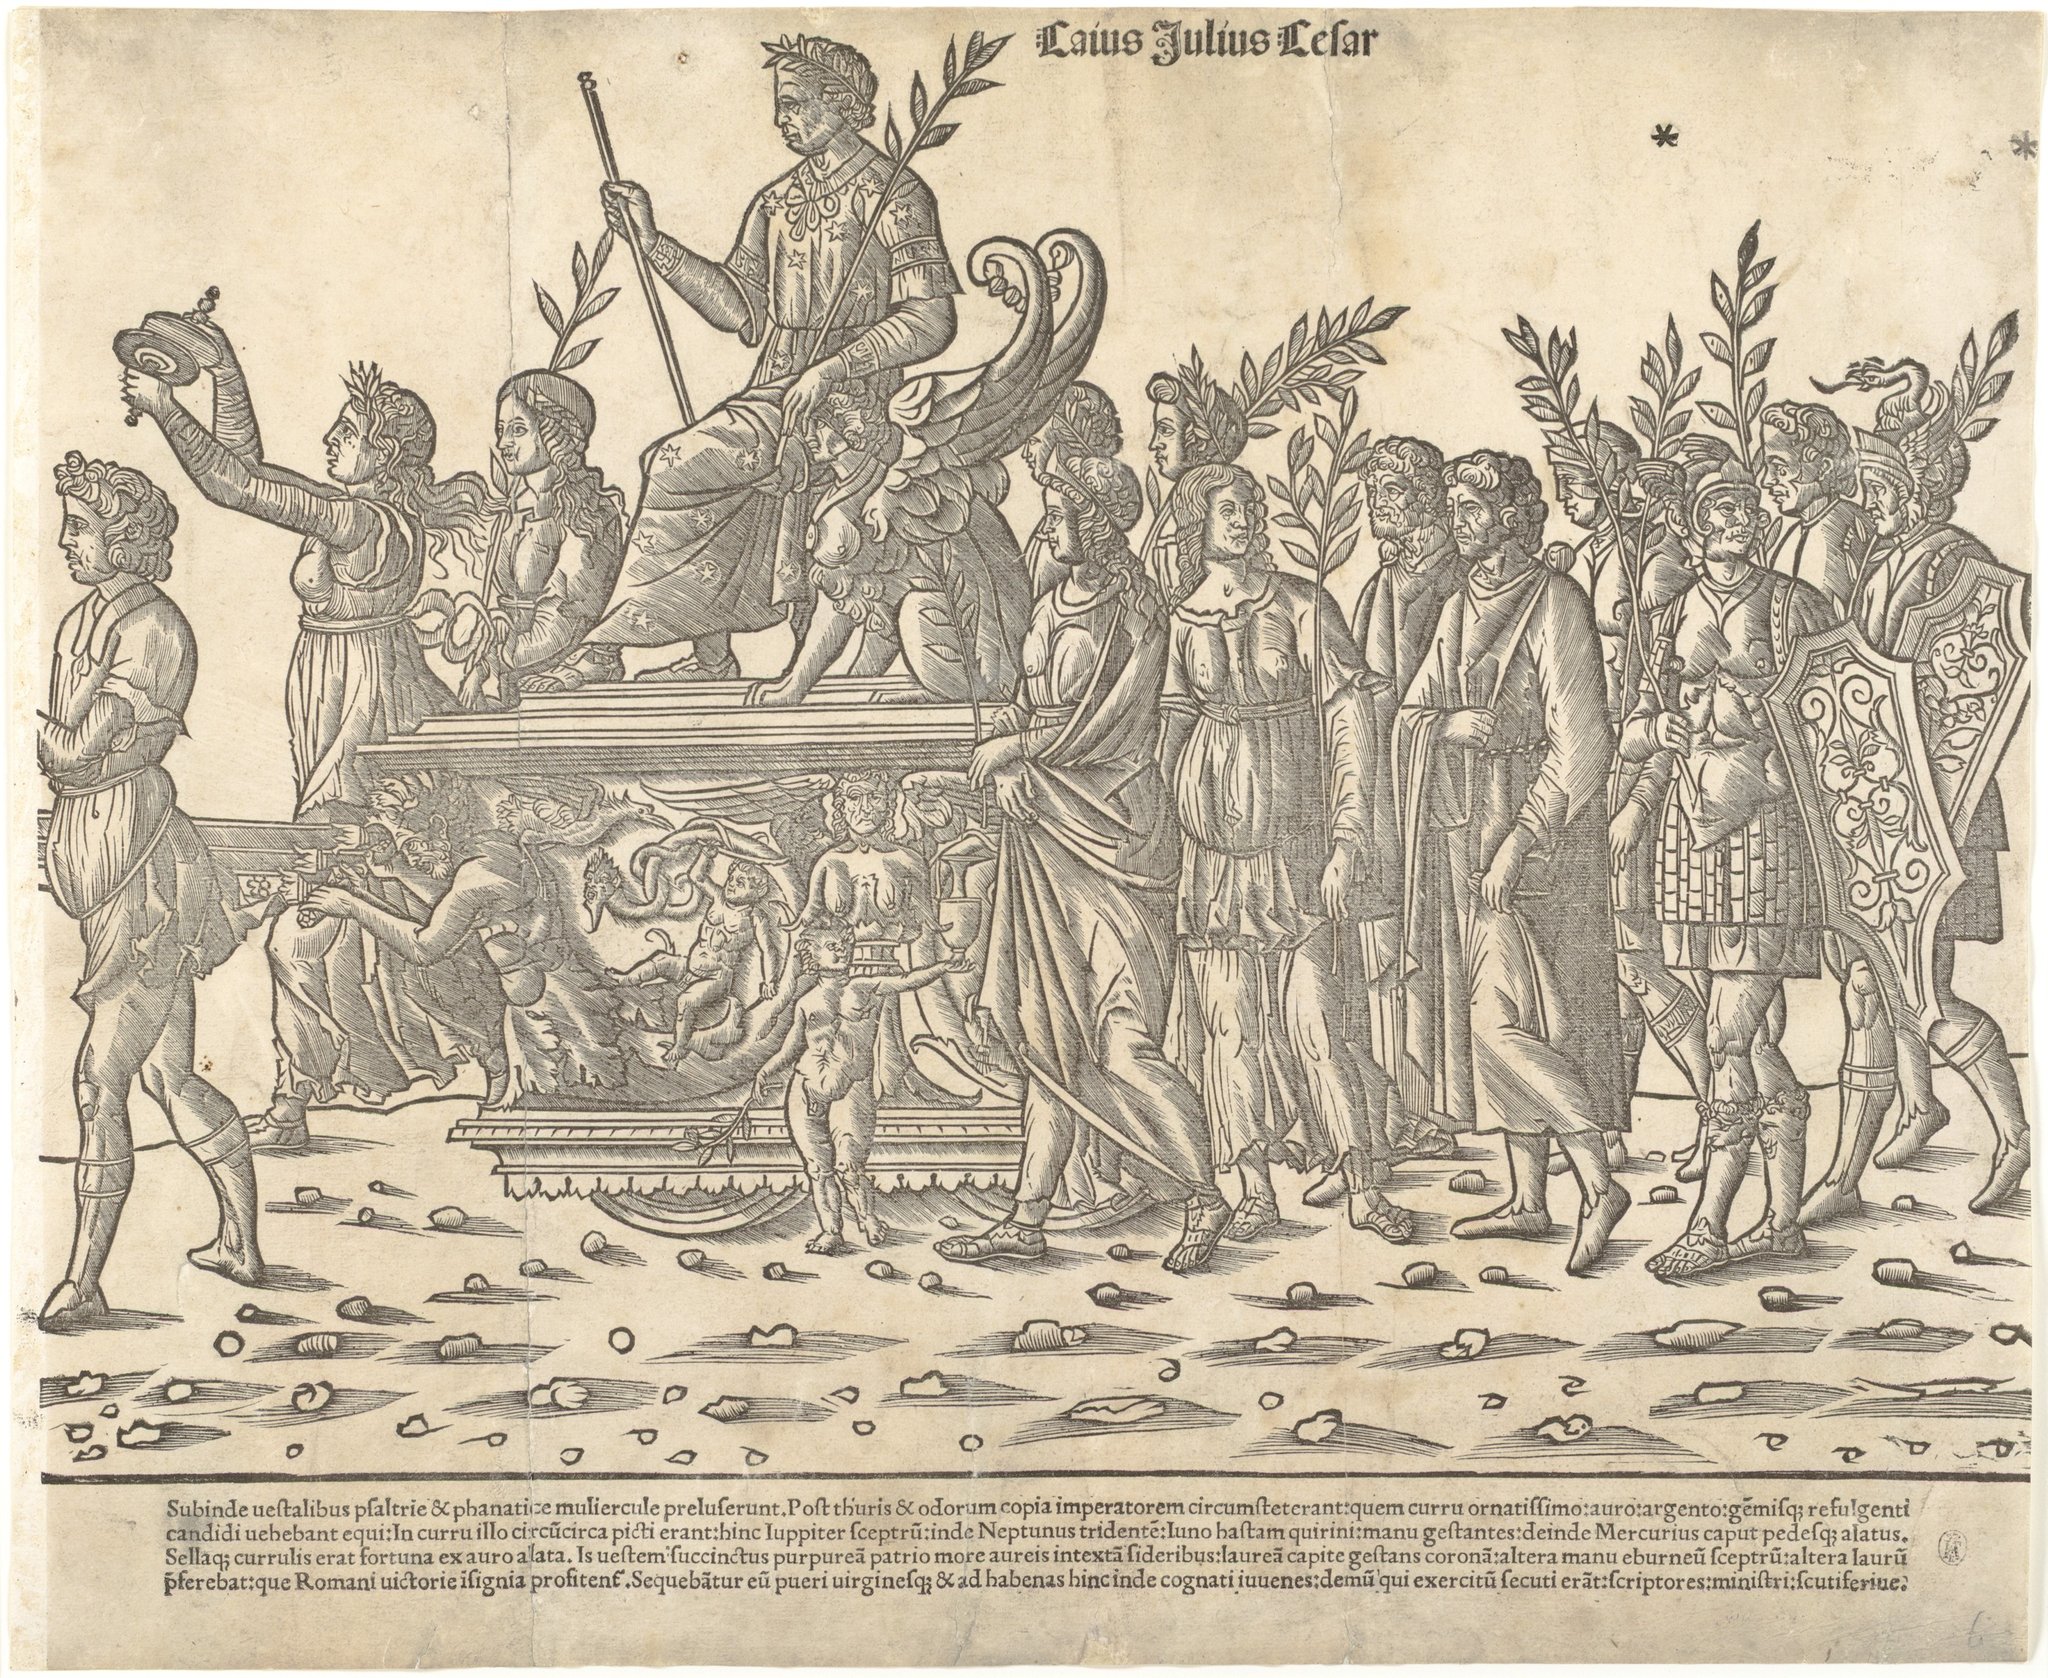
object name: print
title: Caesar riding on his chariot, from "The Triumph of Caesar"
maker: jacob of strasbourg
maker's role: artist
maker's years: 1494-1530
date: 1504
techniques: woodcut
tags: soldiers,julius caesar,women,chariots